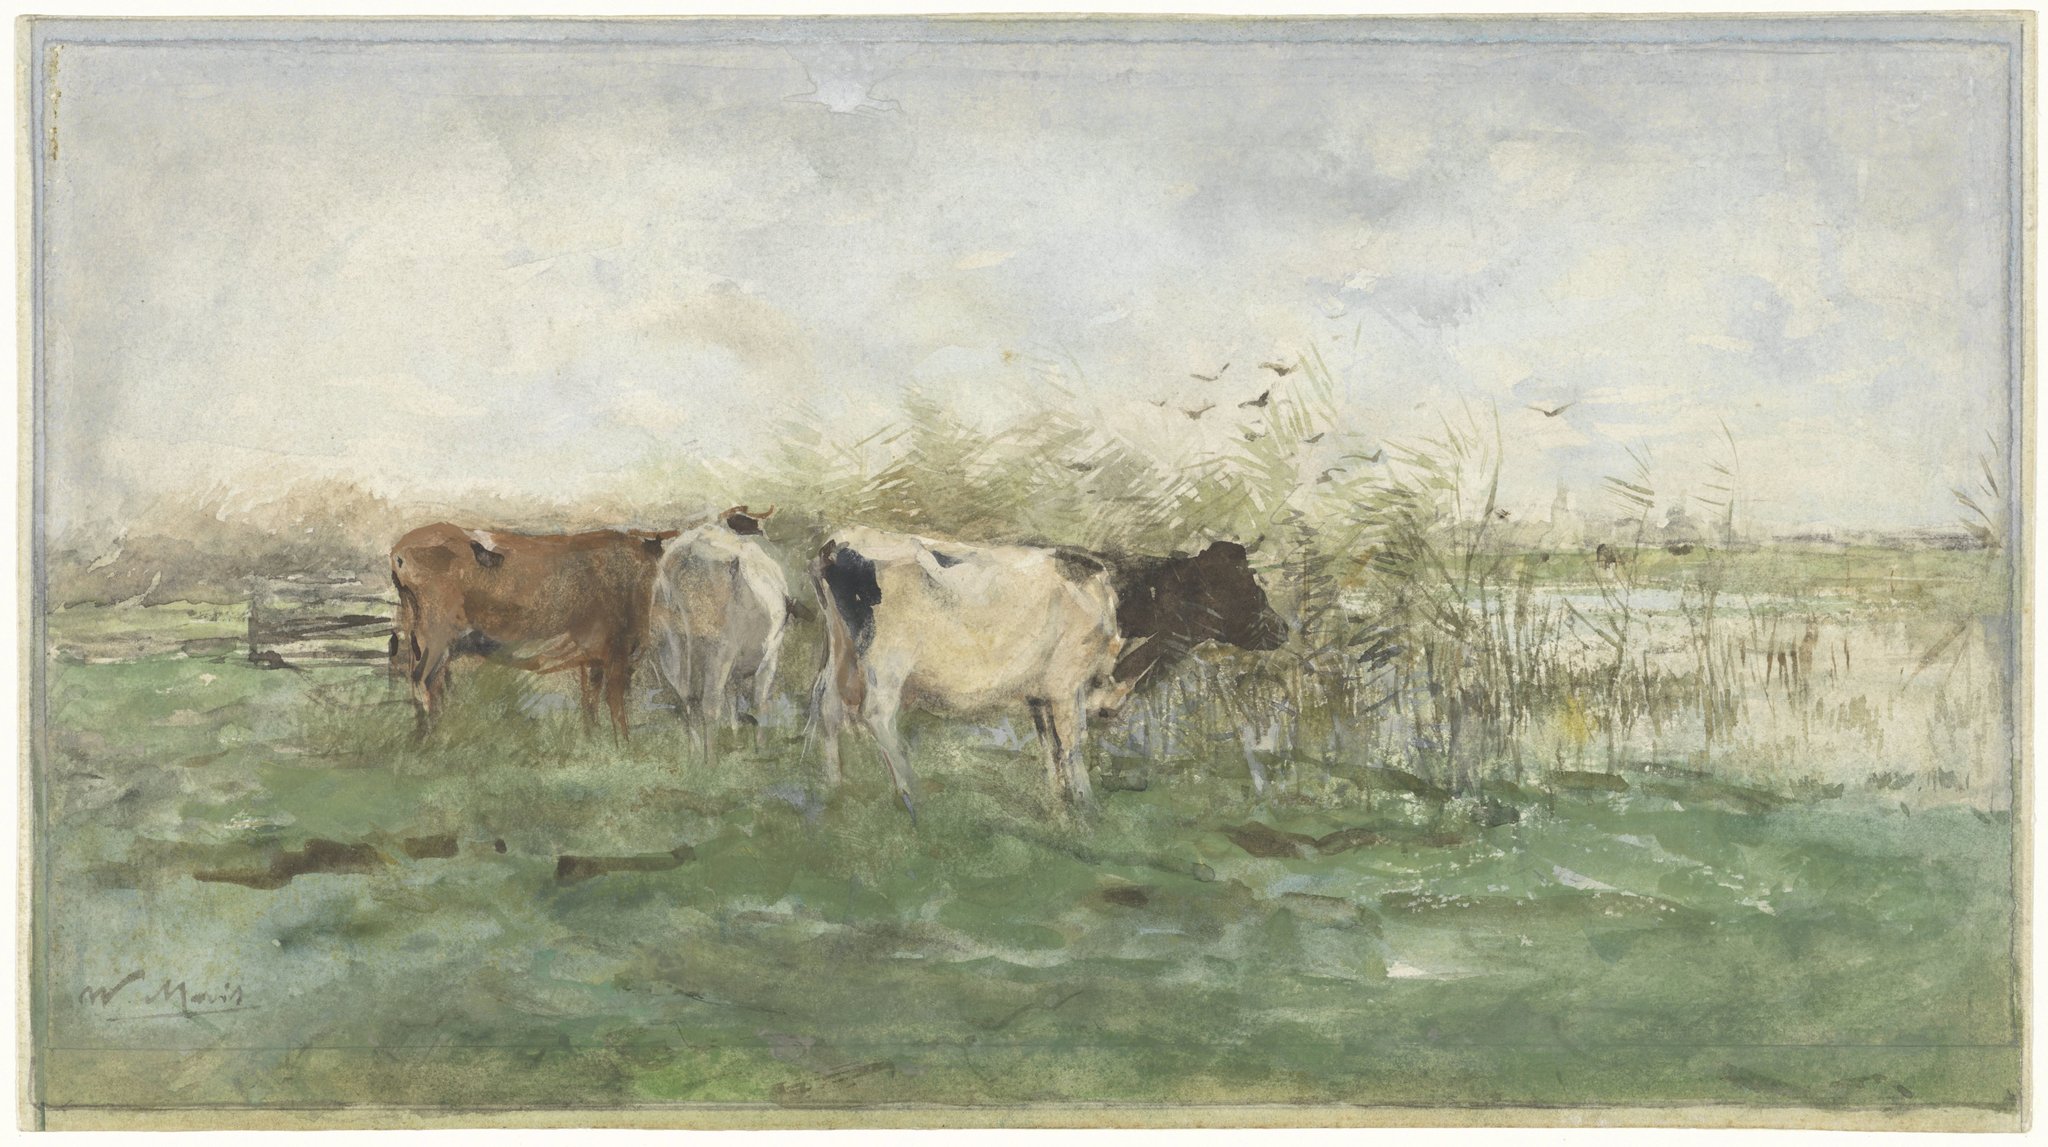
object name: drawing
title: Koeien bij een plas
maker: willem maris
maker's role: draughtsman, painter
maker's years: 1844-1910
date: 1844-1910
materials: paper, watercolor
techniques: brush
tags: cow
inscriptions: signature: ‘W Maris’